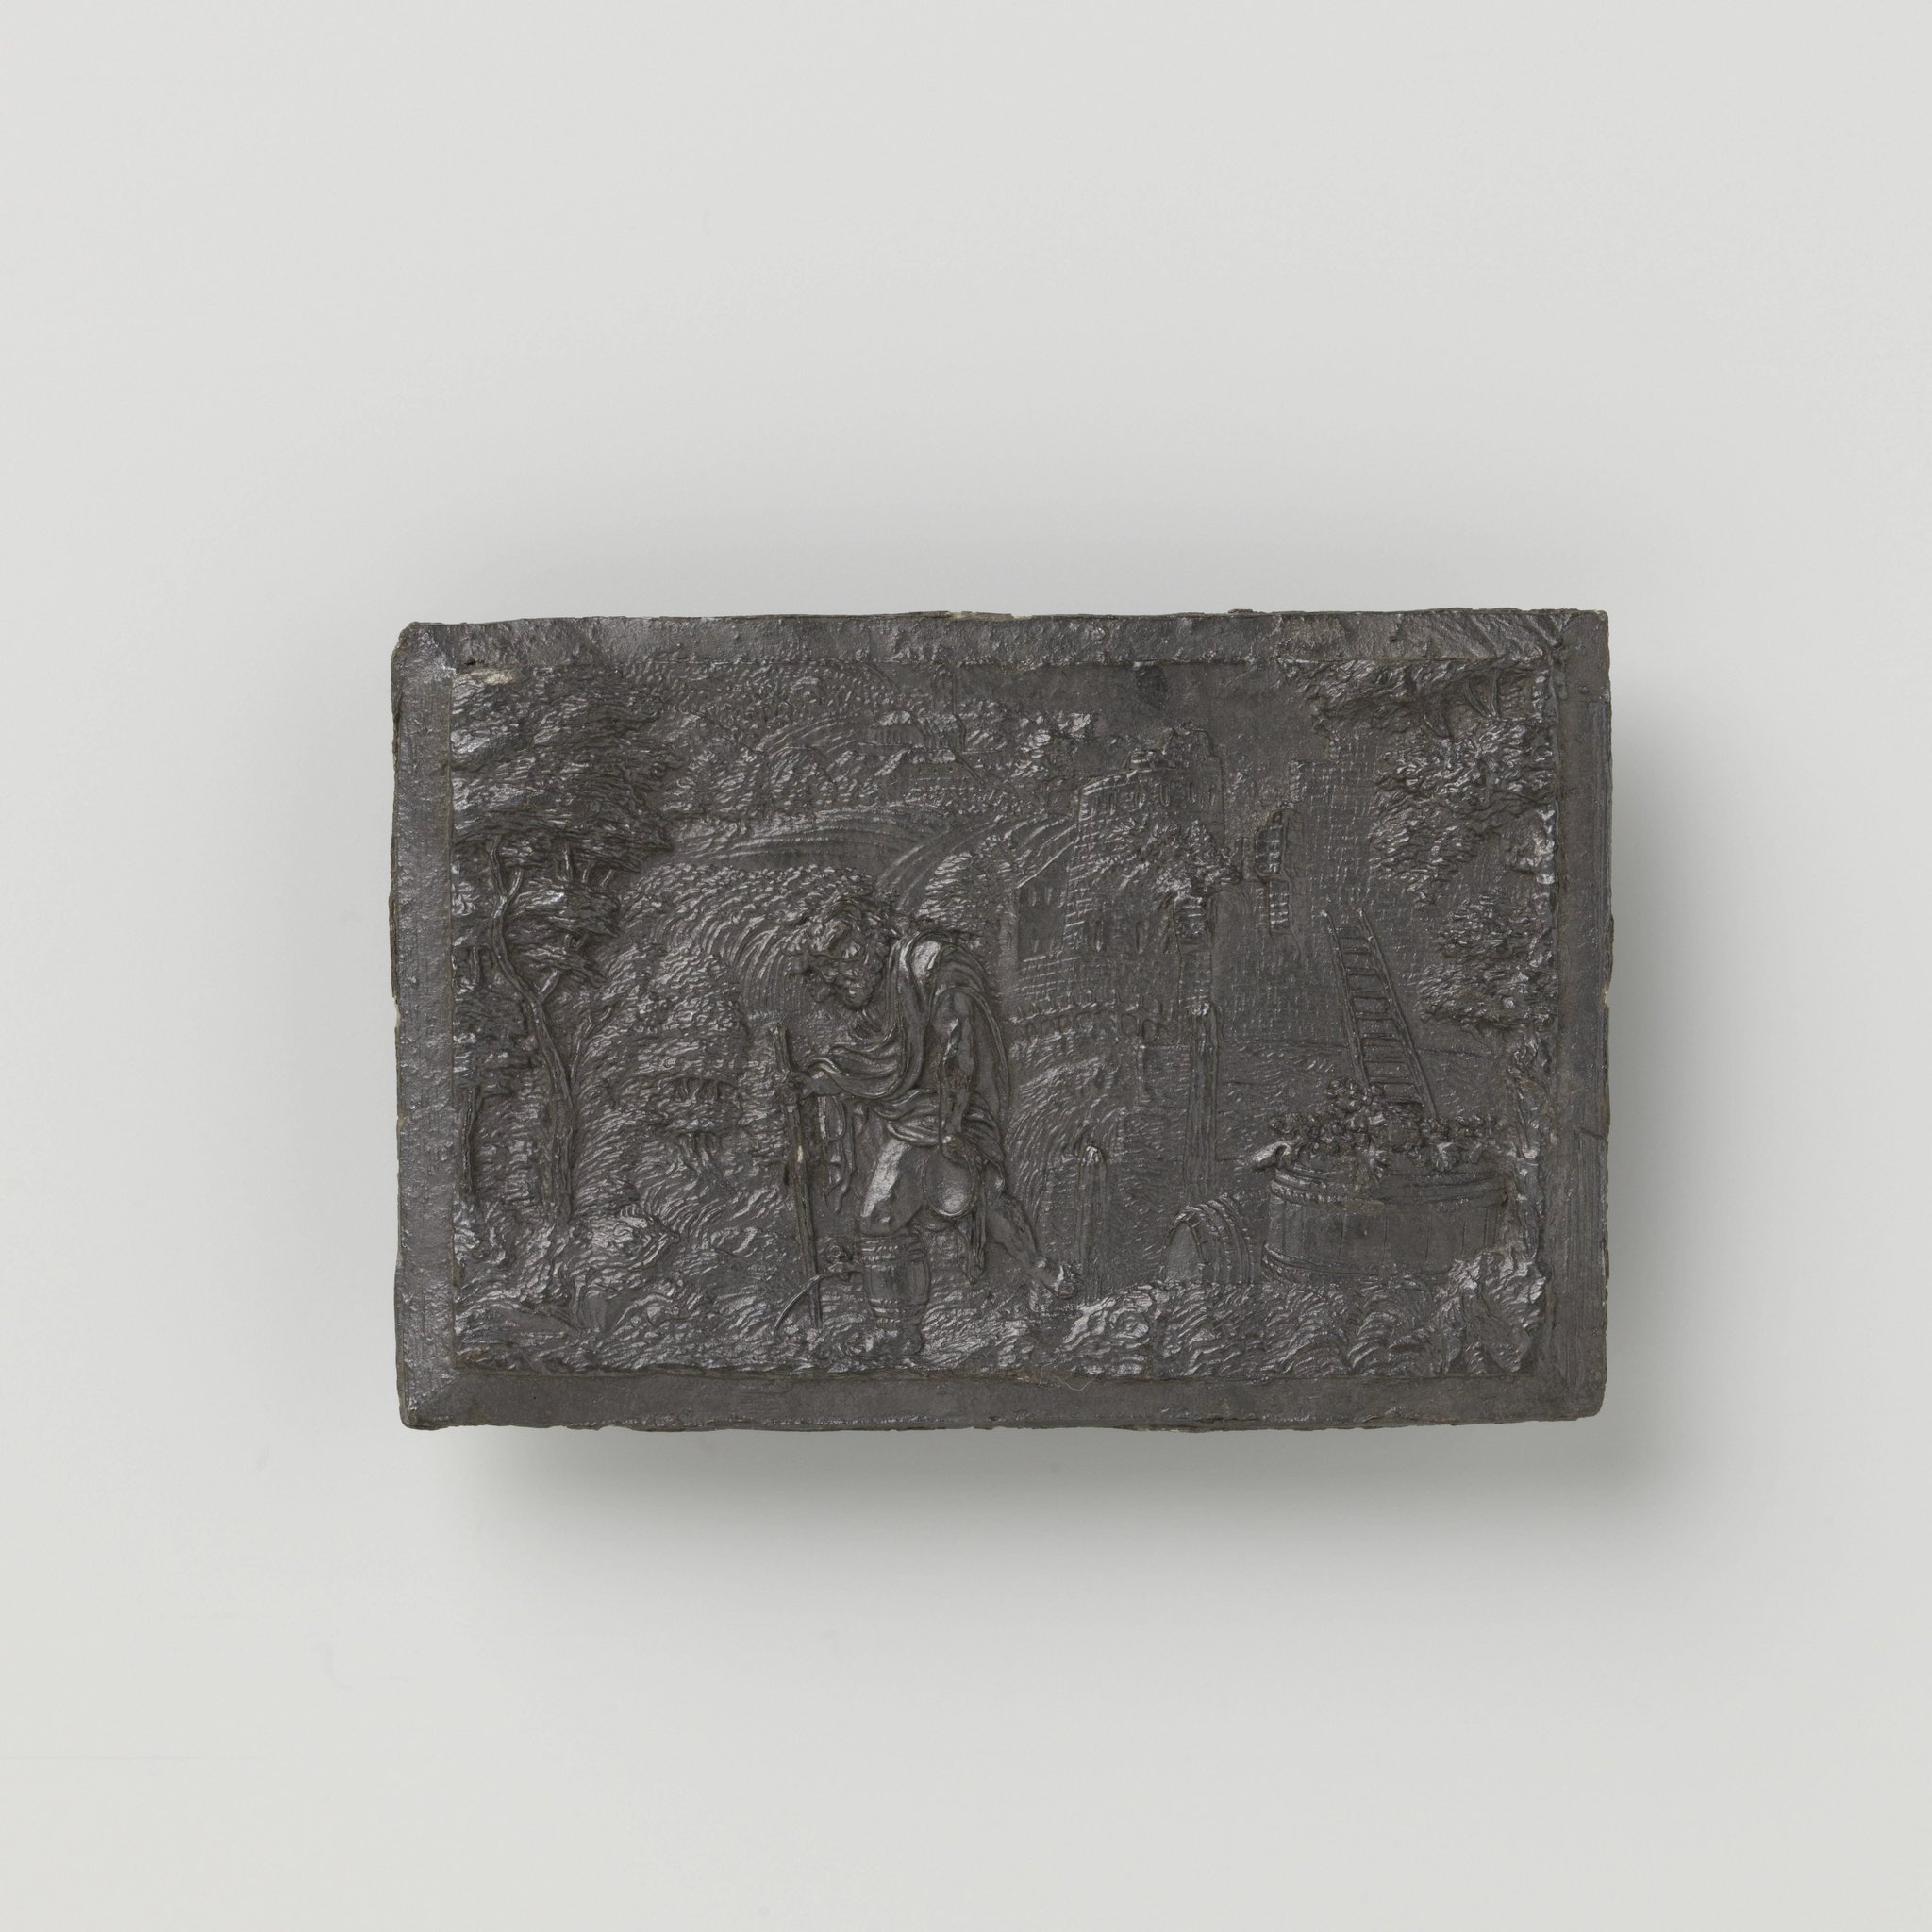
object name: plaque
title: De Bedelaar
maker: peter flötner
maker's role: print maker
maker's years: 1485-1546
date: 1525-1550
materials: lead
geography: nuremberg